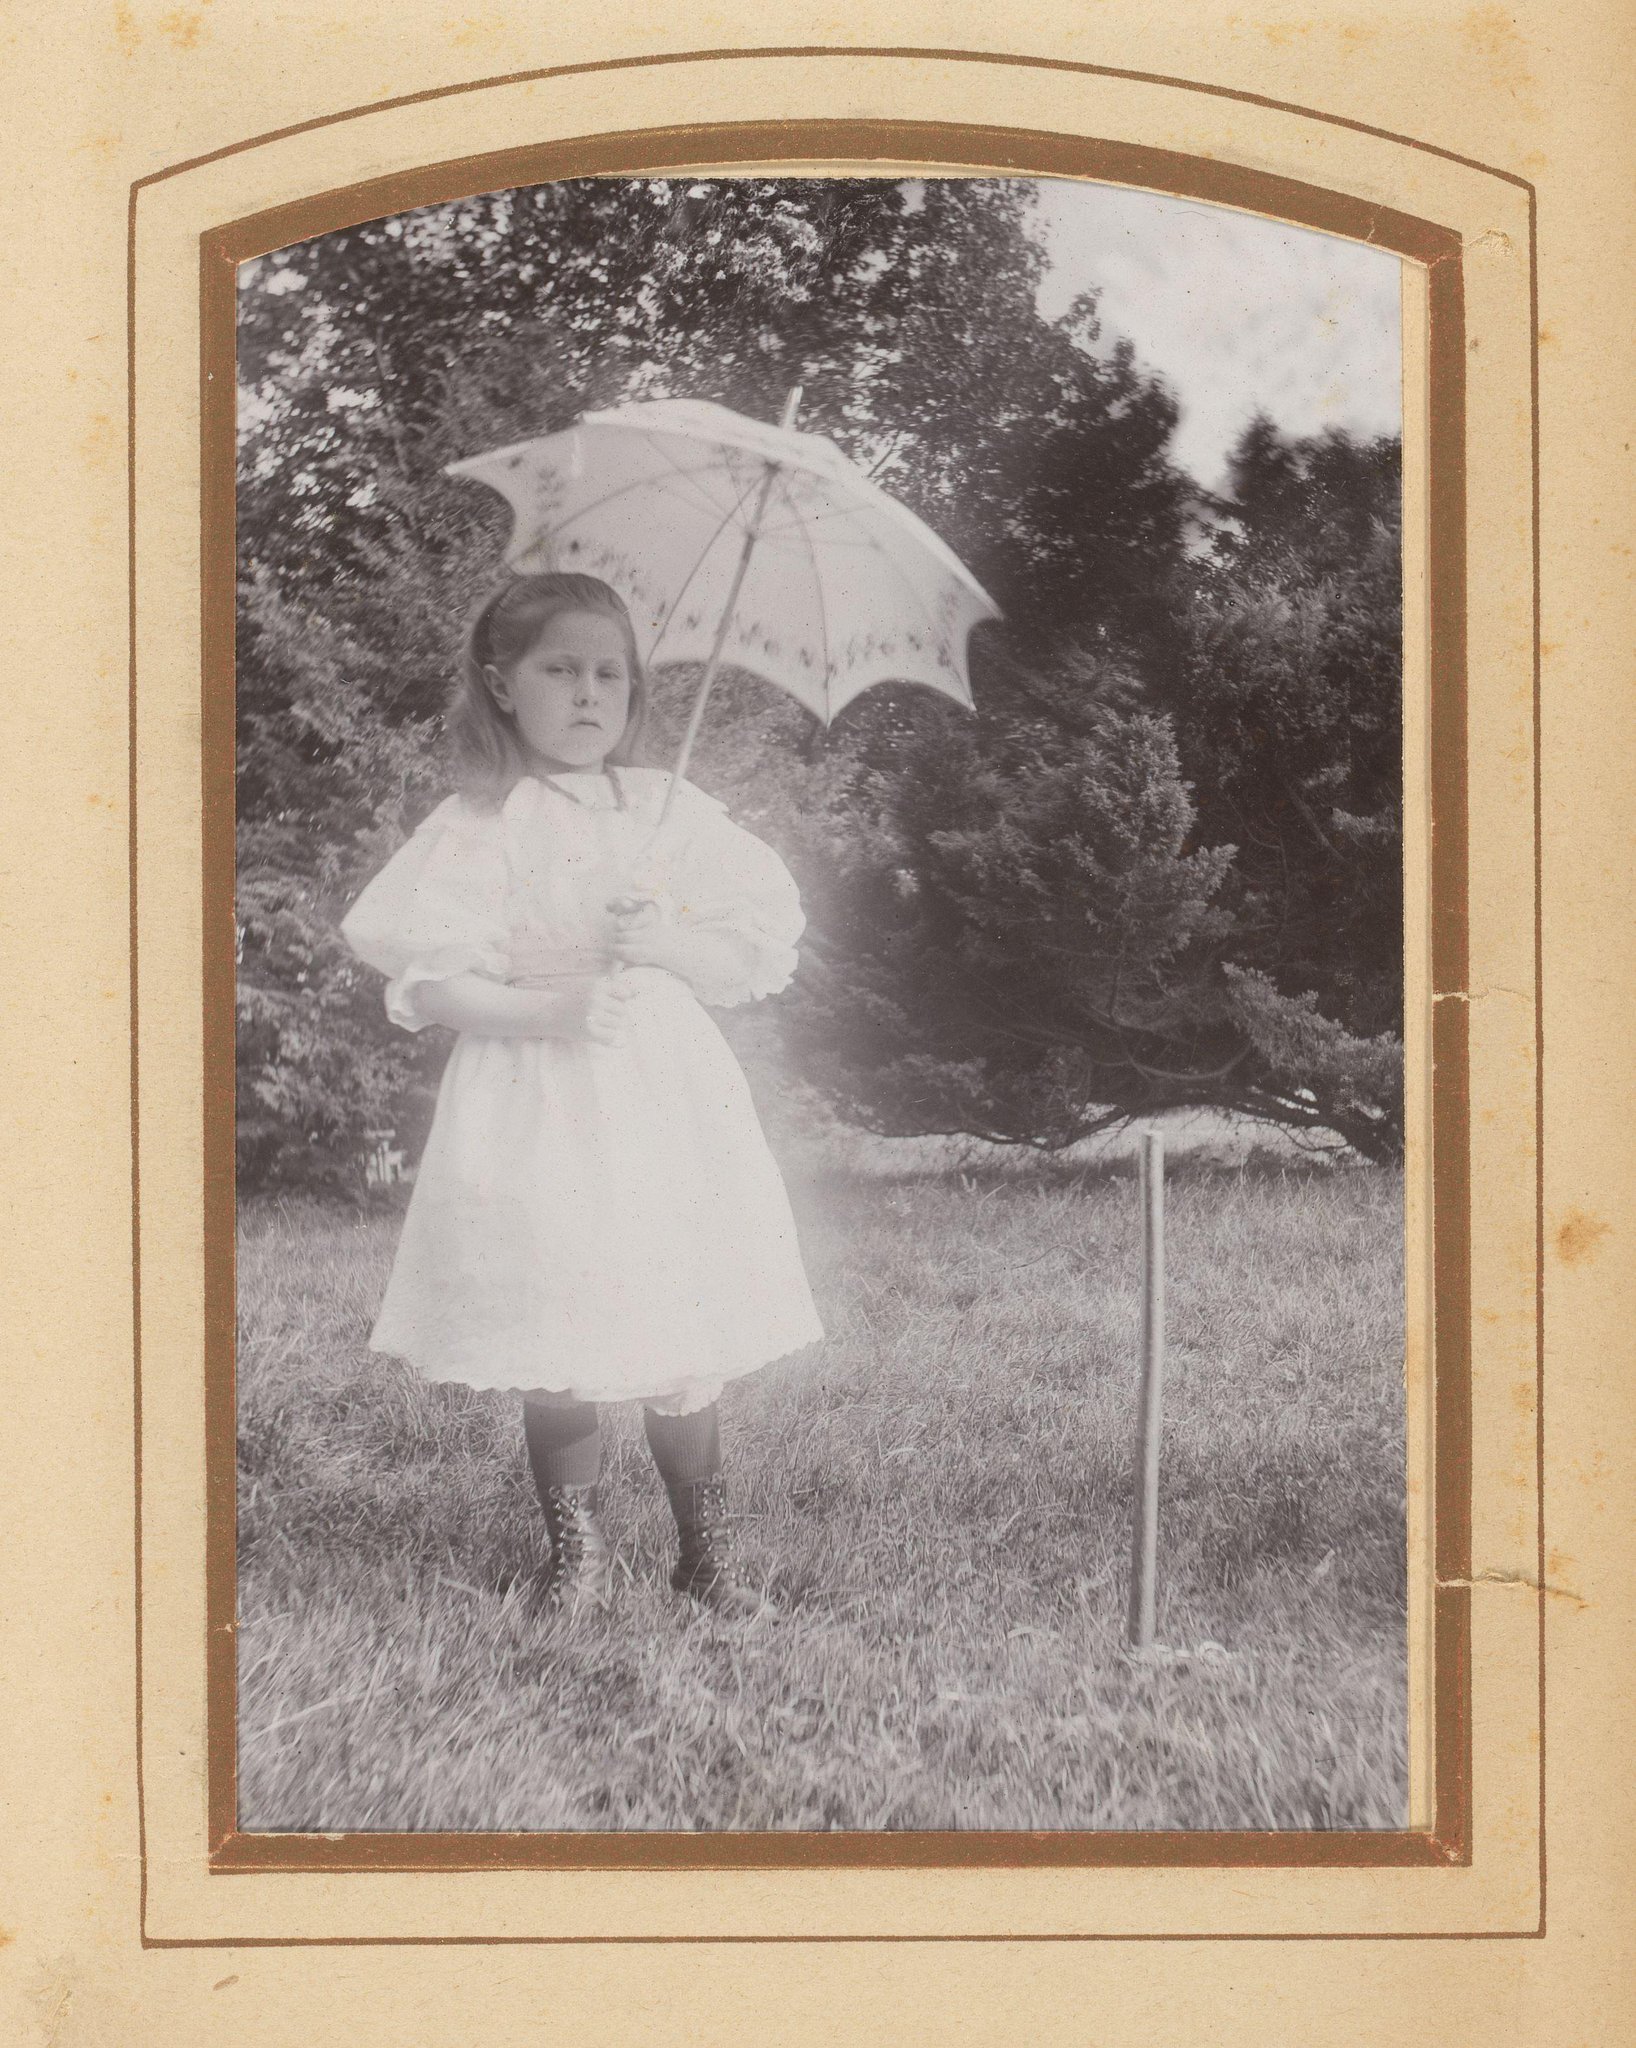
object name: photograph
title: Portret van een meisje, staand in het gras met een paraplu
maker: hendrik jonker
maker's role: fotograaf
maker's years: 1846-1932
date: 1882-1914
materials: cardboard, photographic support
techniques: collodion silver print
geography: leiden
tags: girl (child between toddler and youth), umbrella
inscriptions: inscription: ‘H. Jonker/ Photographisch Atelier/ Leiden/ Apothekersdijk No.7.’, number: ‘98’